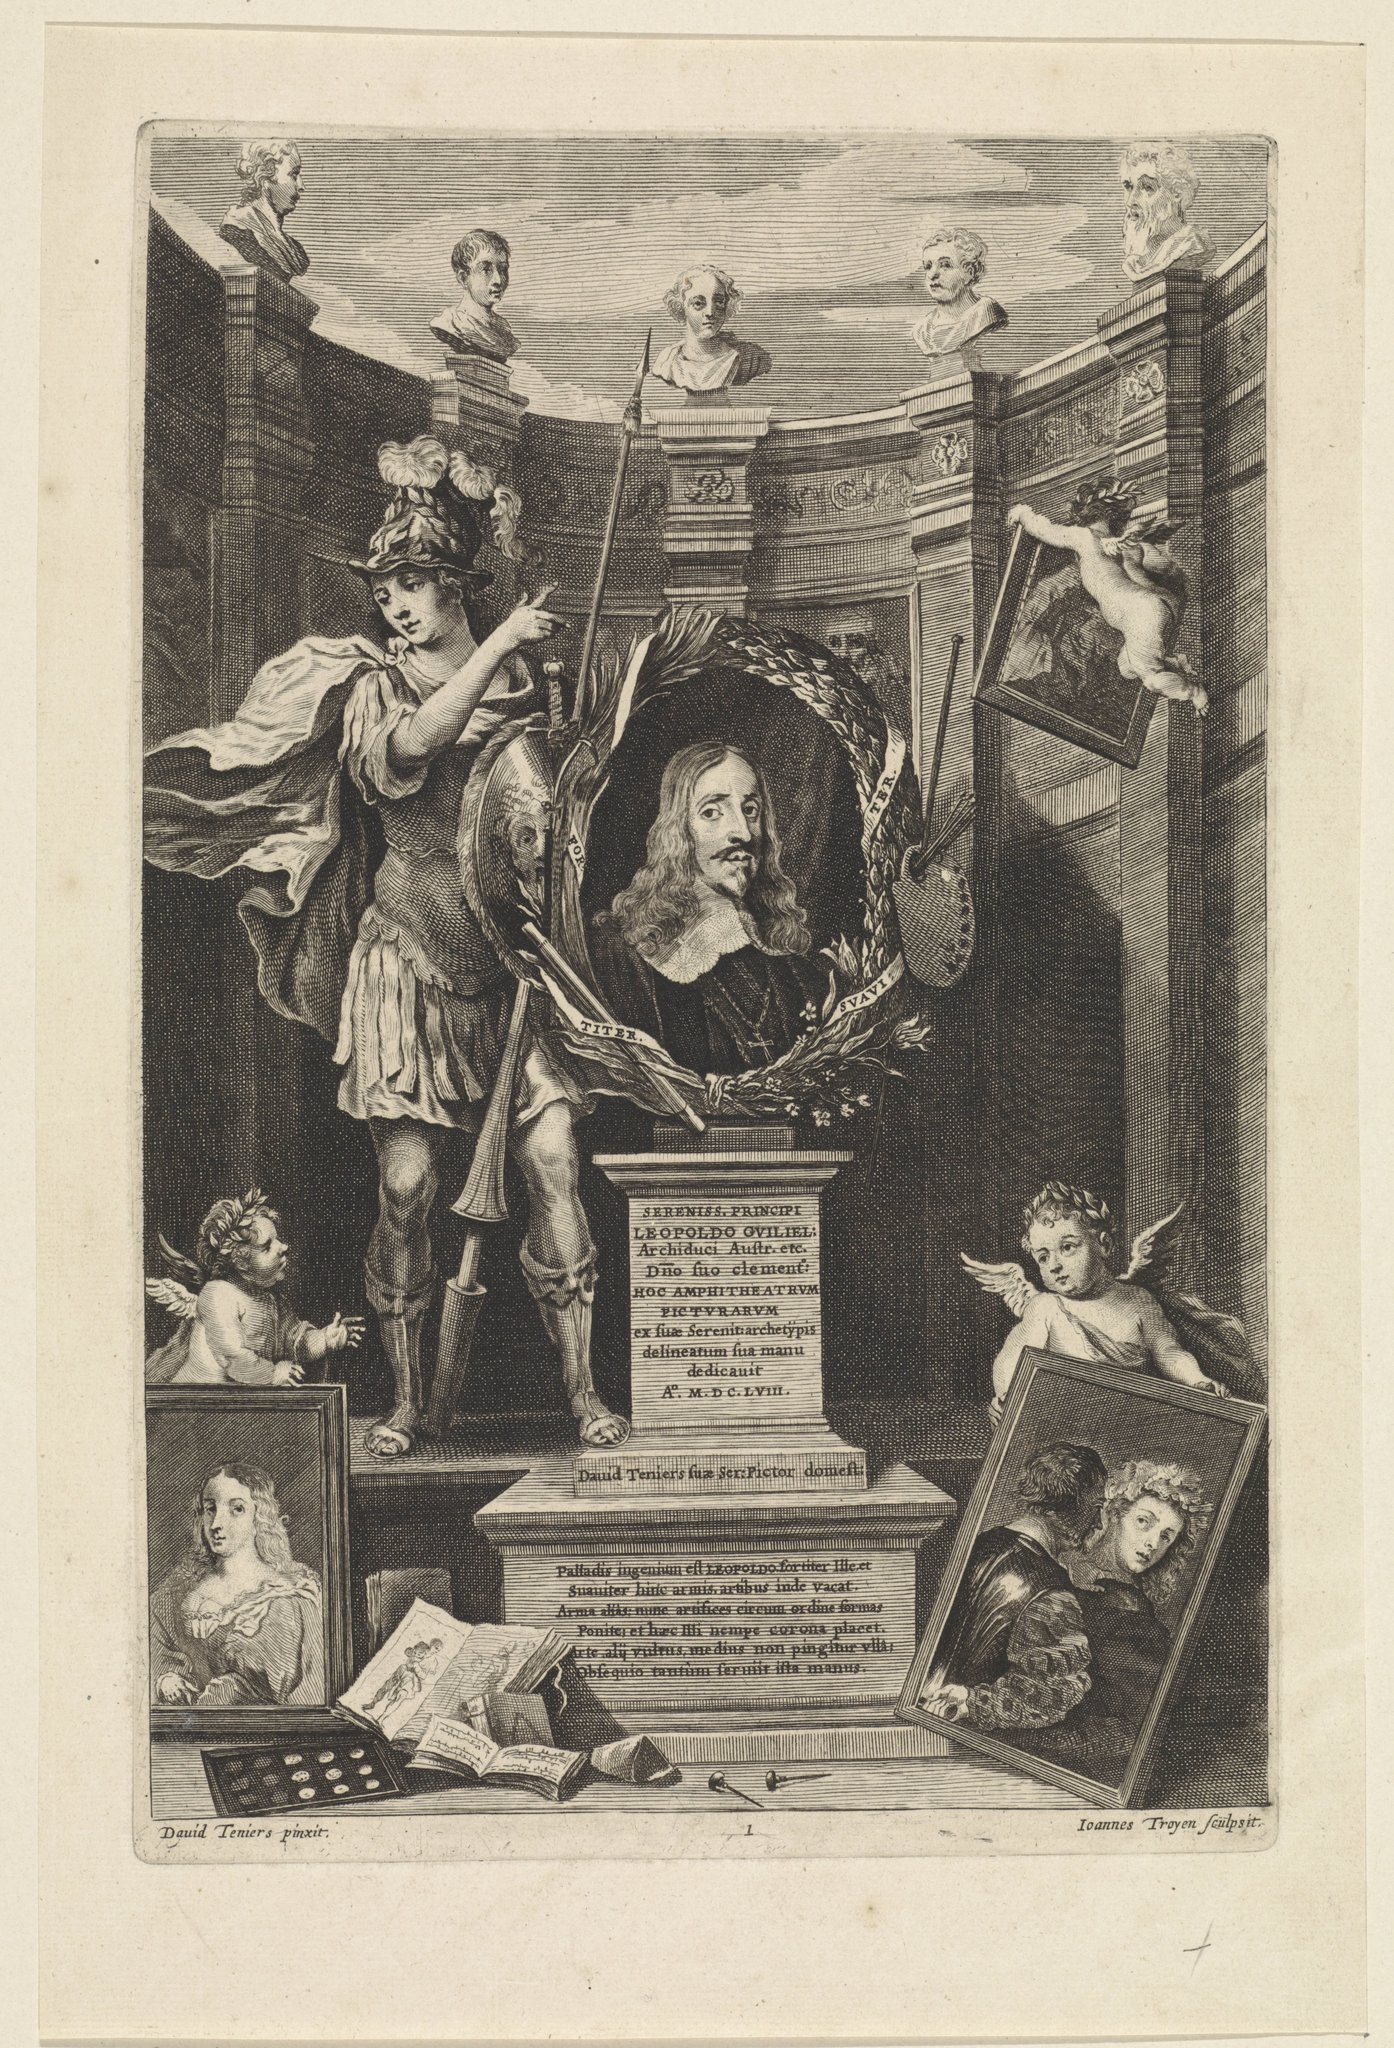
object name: titelblad, titelpagina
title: Titelpagina voor: David Teniers, Theatrum Pictorium, 1658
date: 1658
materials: paper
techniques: engraving, etching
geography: brussels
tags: vienna, leopold willem van oostenrijk (landvoogd der zuidelijke nederlanden), minerva as patroness, picture, painting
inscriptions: collector's mark: Lugt 2228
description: Portret van Leopold Willem, aartshertog van Oostenrijk en landvoogd van de Zuidelijke Nederlanden, in een ovale lijst met zijn motto, op een piëdestal met een opdracht aan hem in het Latijn. Naast zijn portret staat Minerva als beschermster van de kunsten. Naast het piëdestal schilderijen uit de collectie van Leopold Willem. Linksonder een verzameling munten, een boek met tekeningen en een muziekboek.